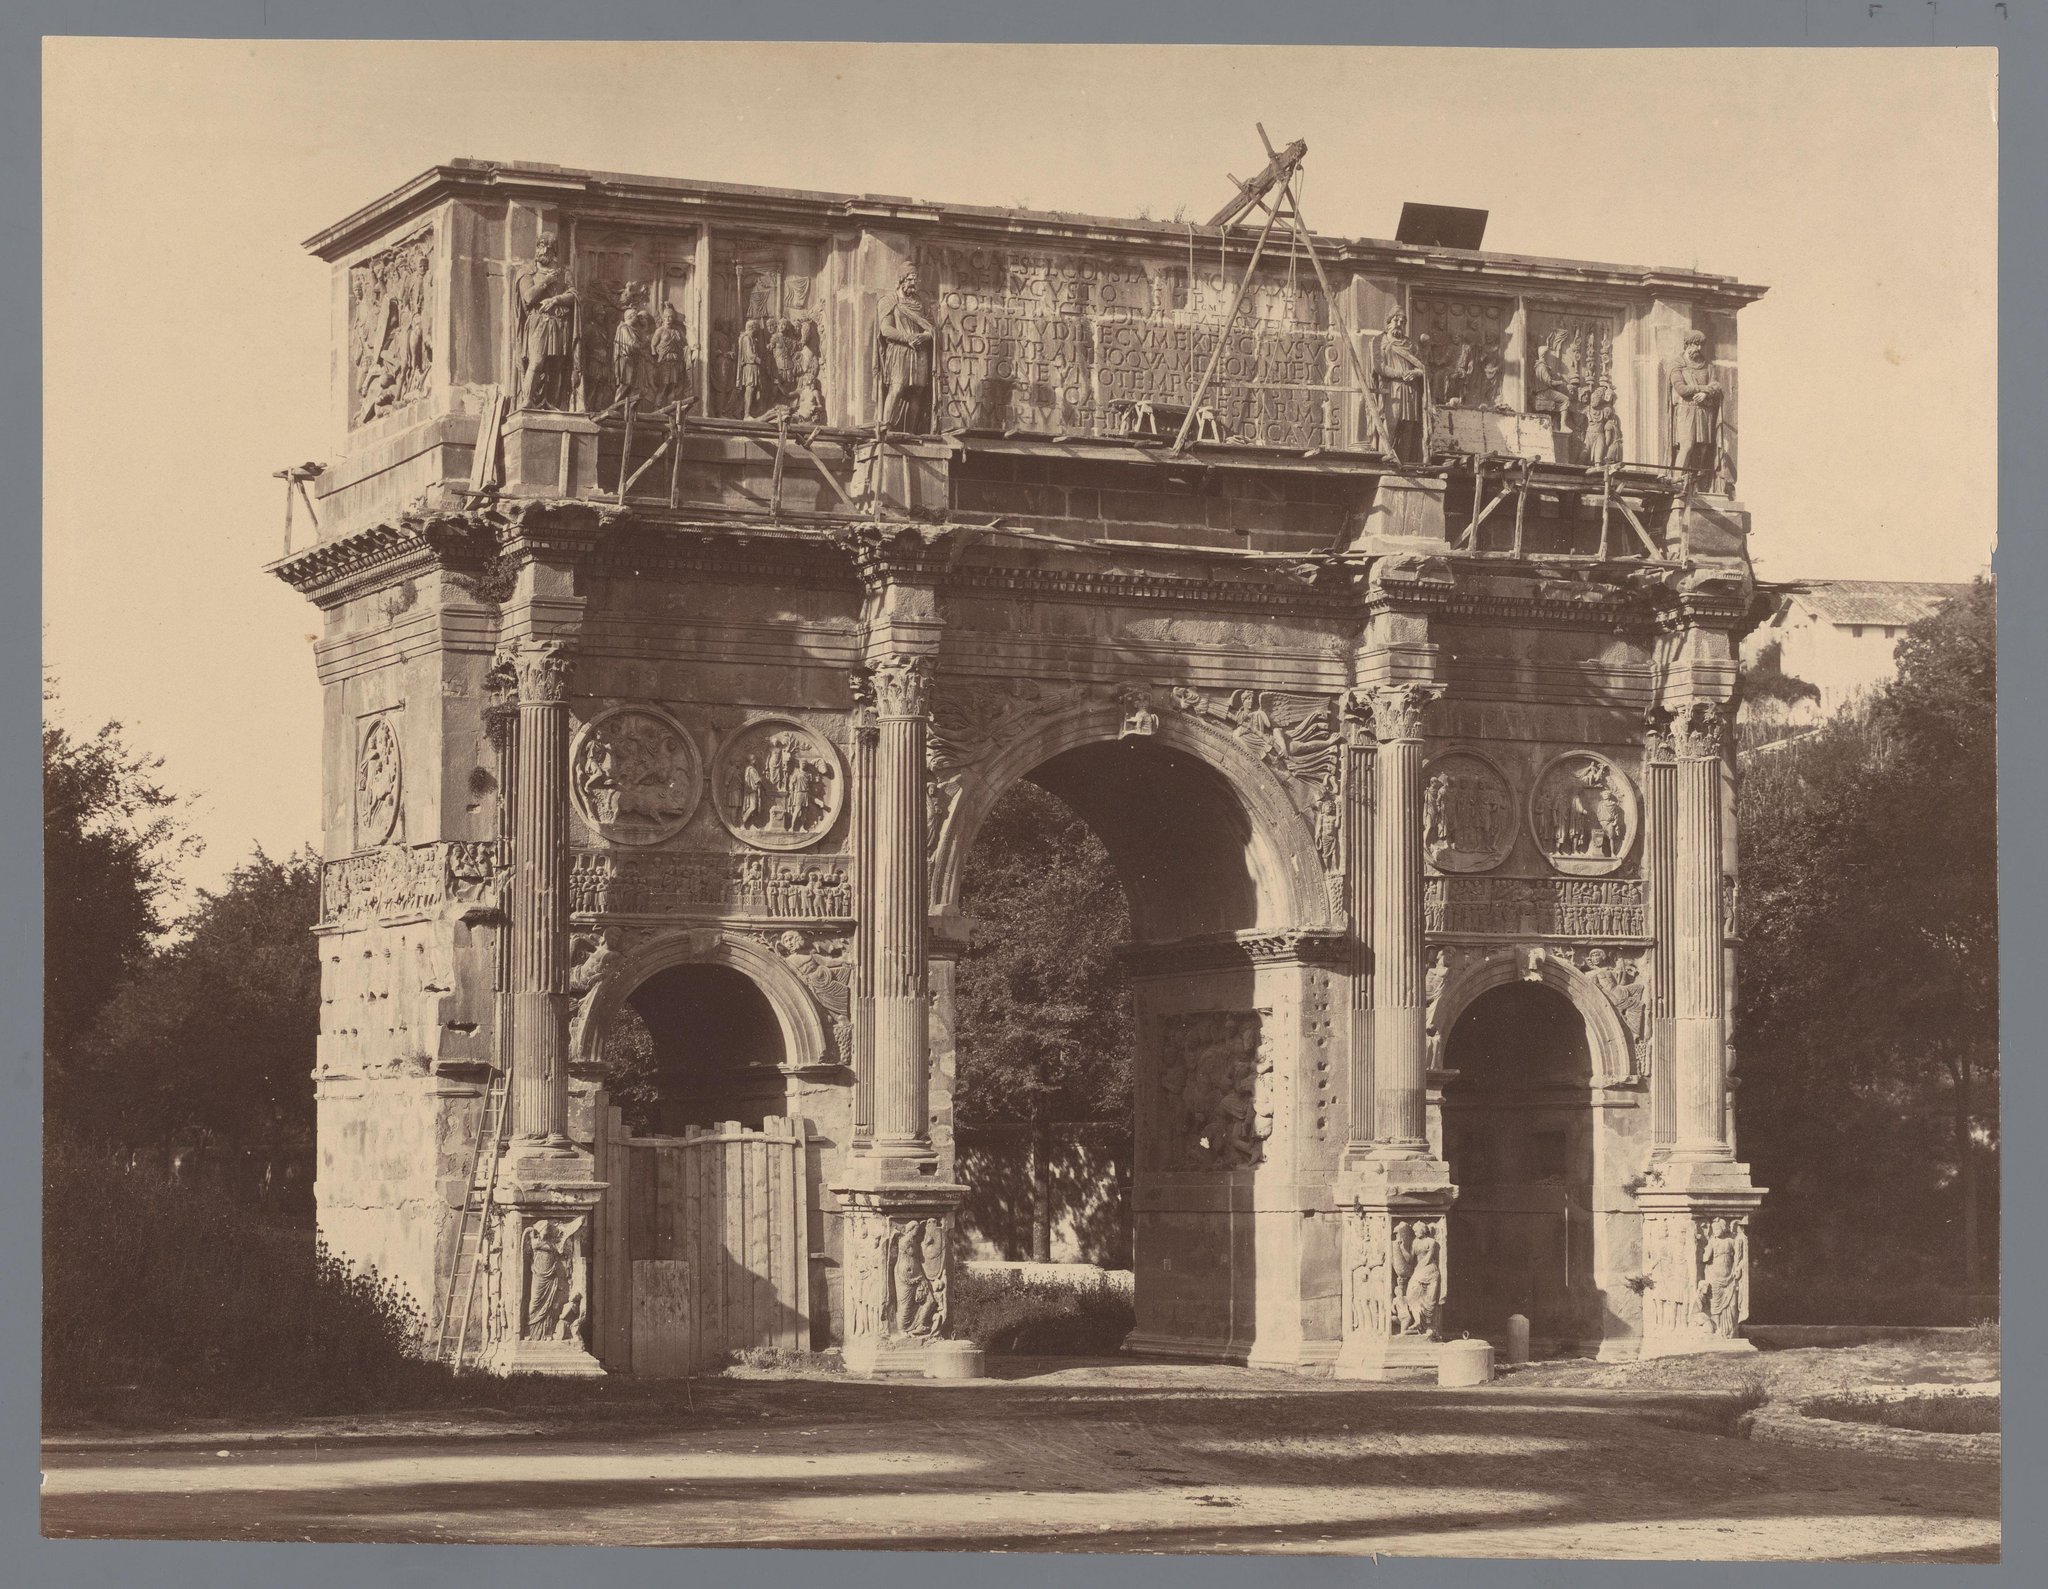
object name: photograph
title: Rome, Boog van Constantijn tijdens restauratie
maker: Anonymous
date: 1850-1870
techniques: albumen print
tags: arch of constantine